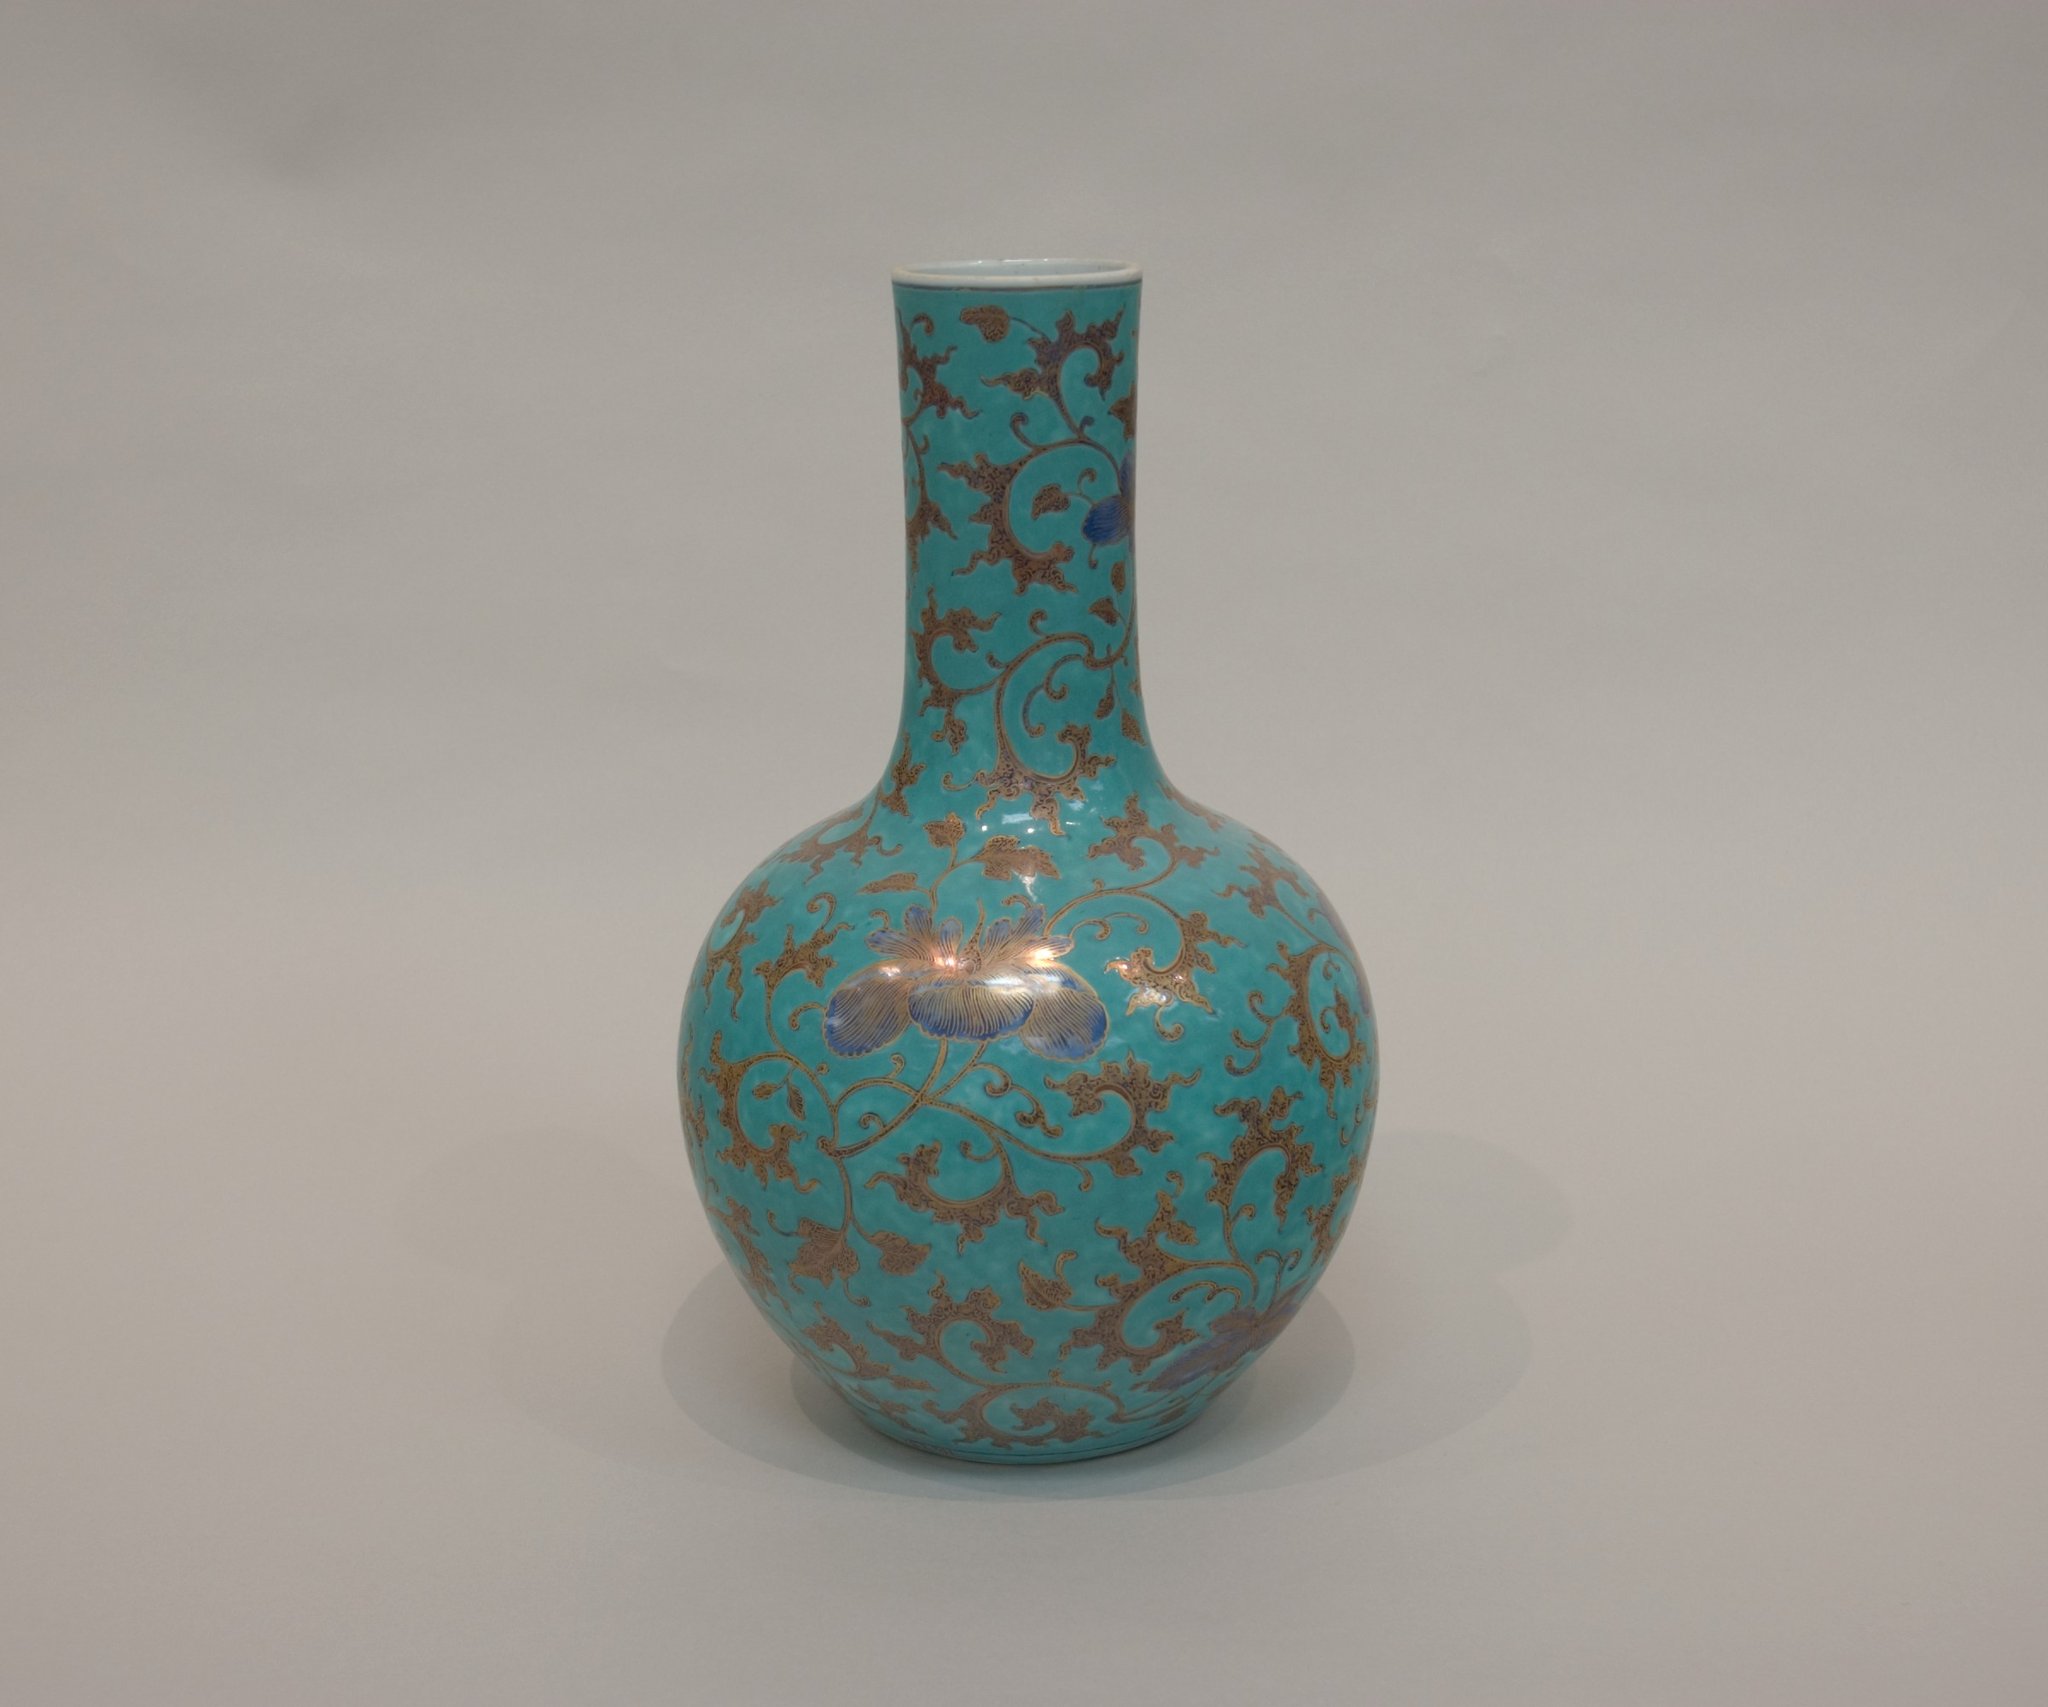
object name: vase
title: Vase with floral scrolls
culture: chinese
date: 1767-1800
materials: cobalt, enamel, porcelain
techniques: gilding, overglaze, painting, underglaze